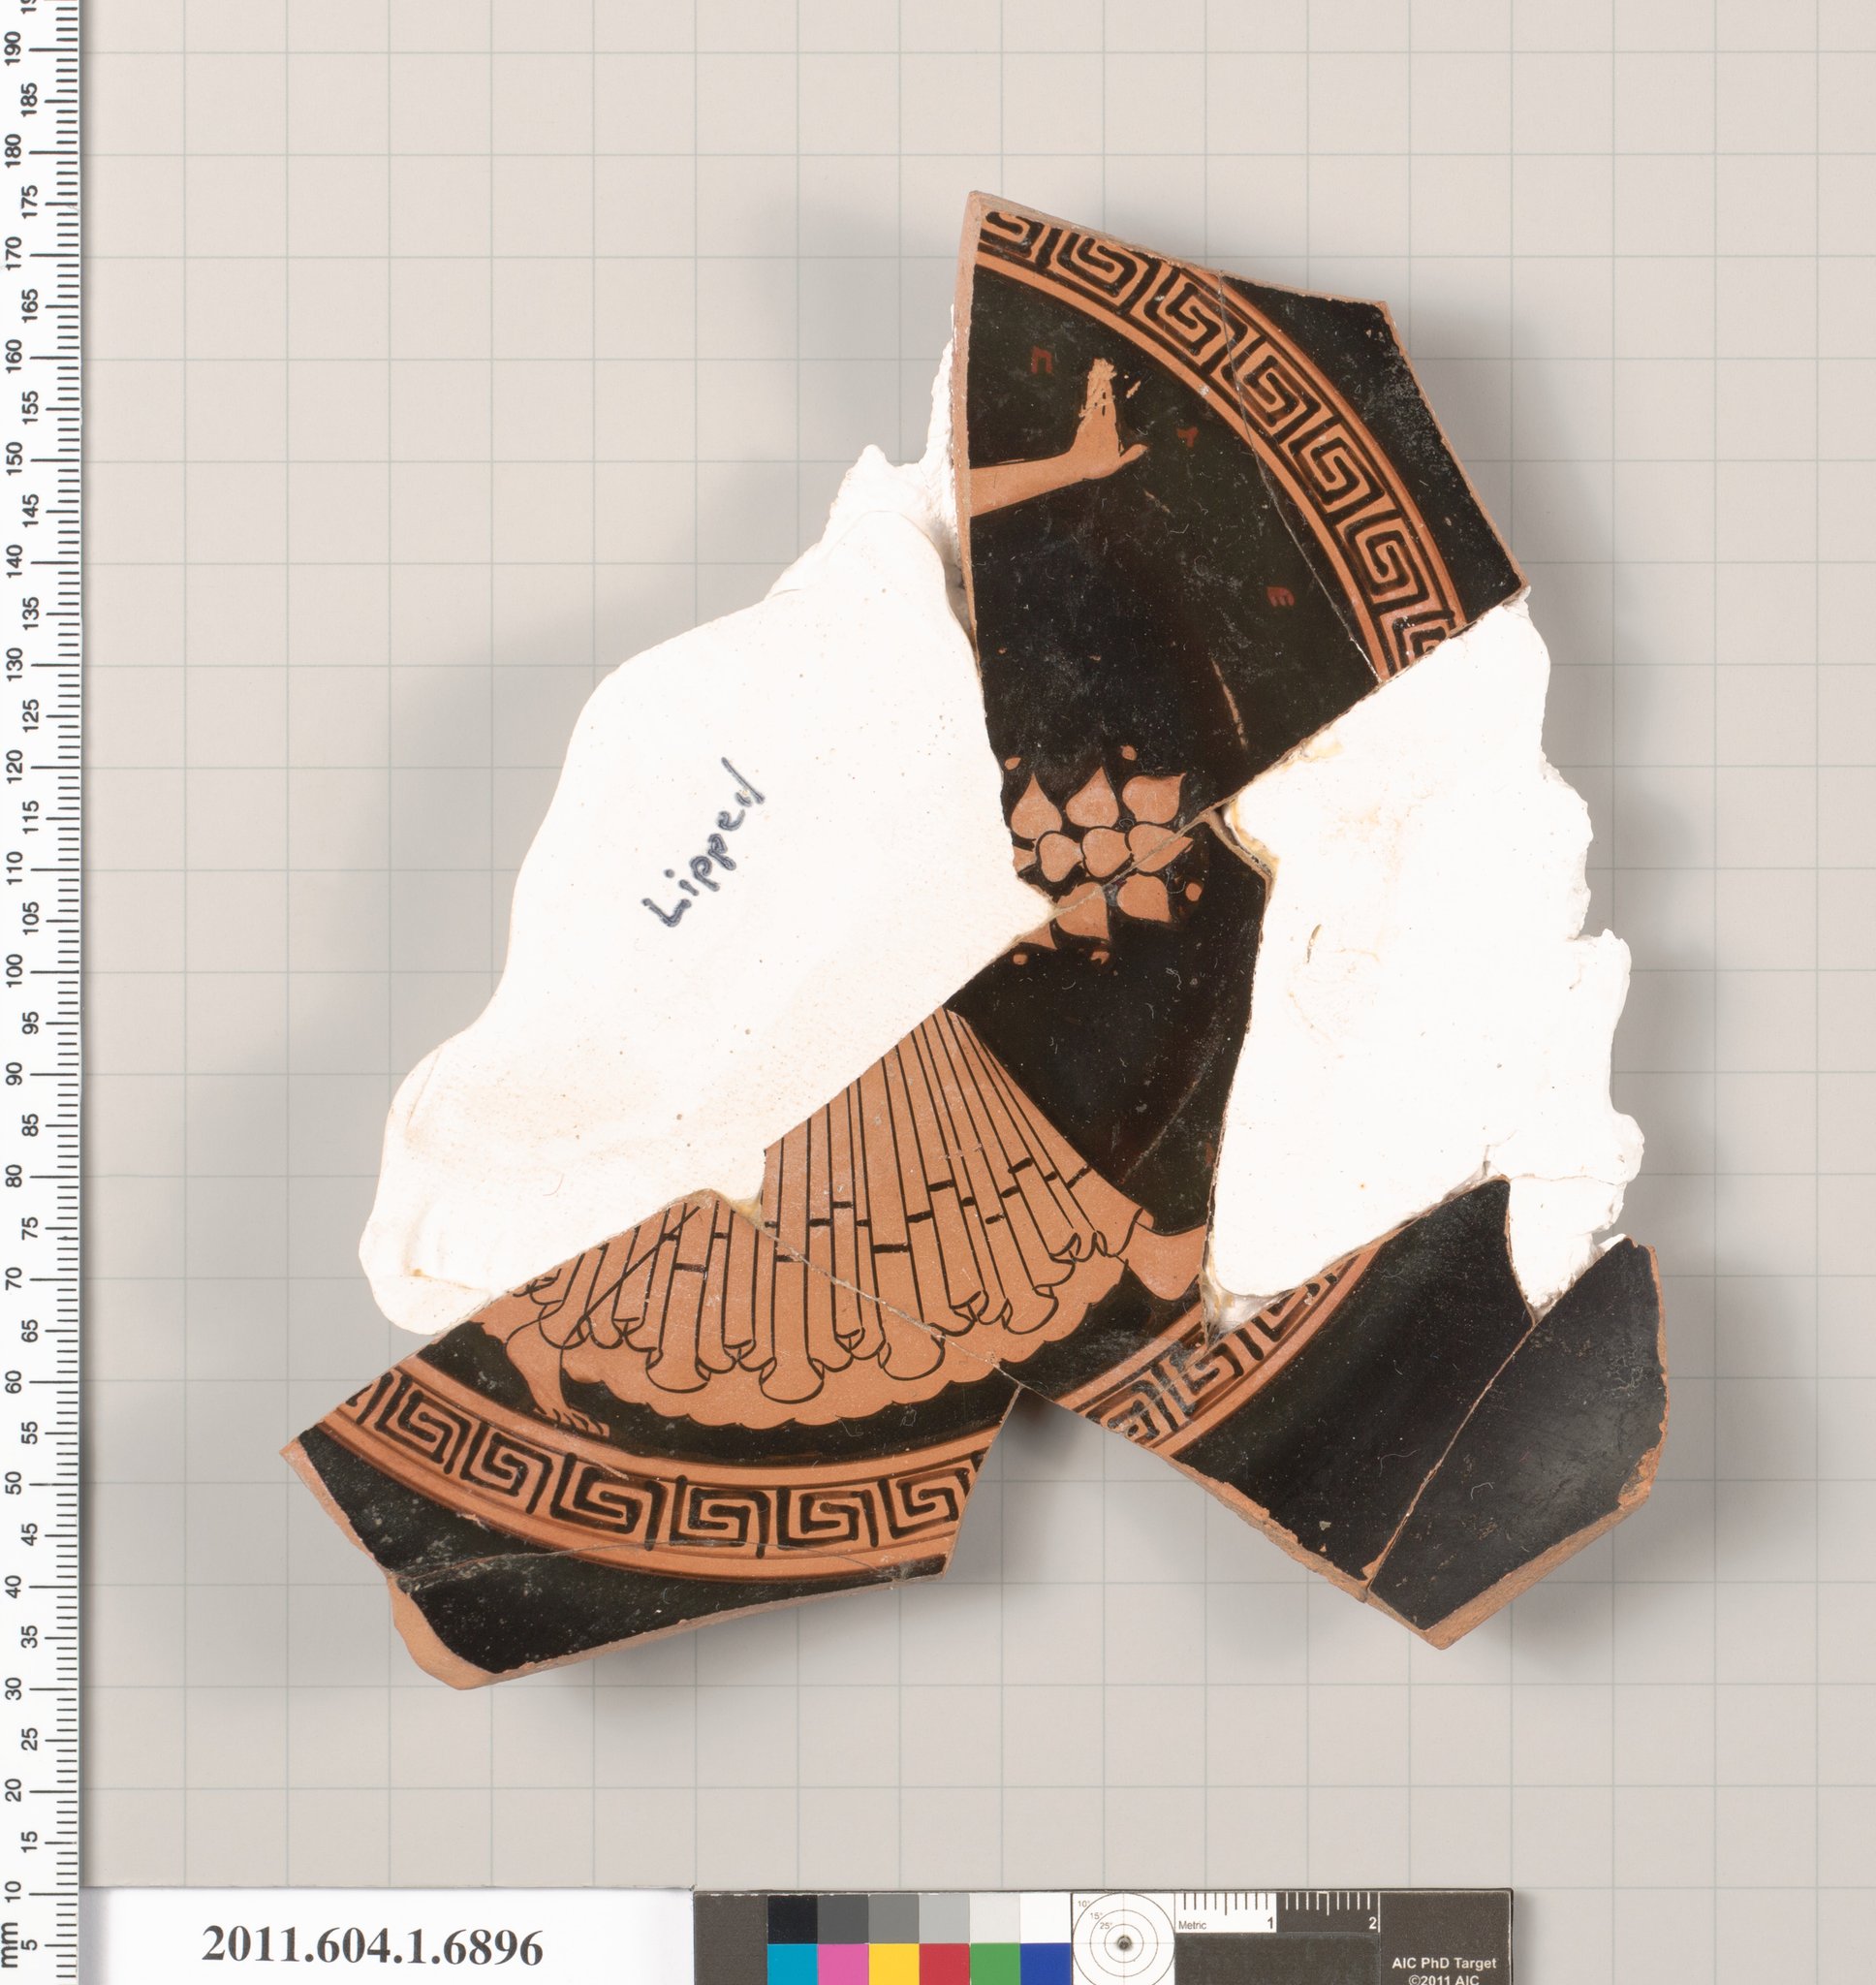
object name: kylix fragment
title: Terracotta fragment of a kylix (drinking cup)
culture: greek, attic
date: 490-470 BCE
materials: terracotta